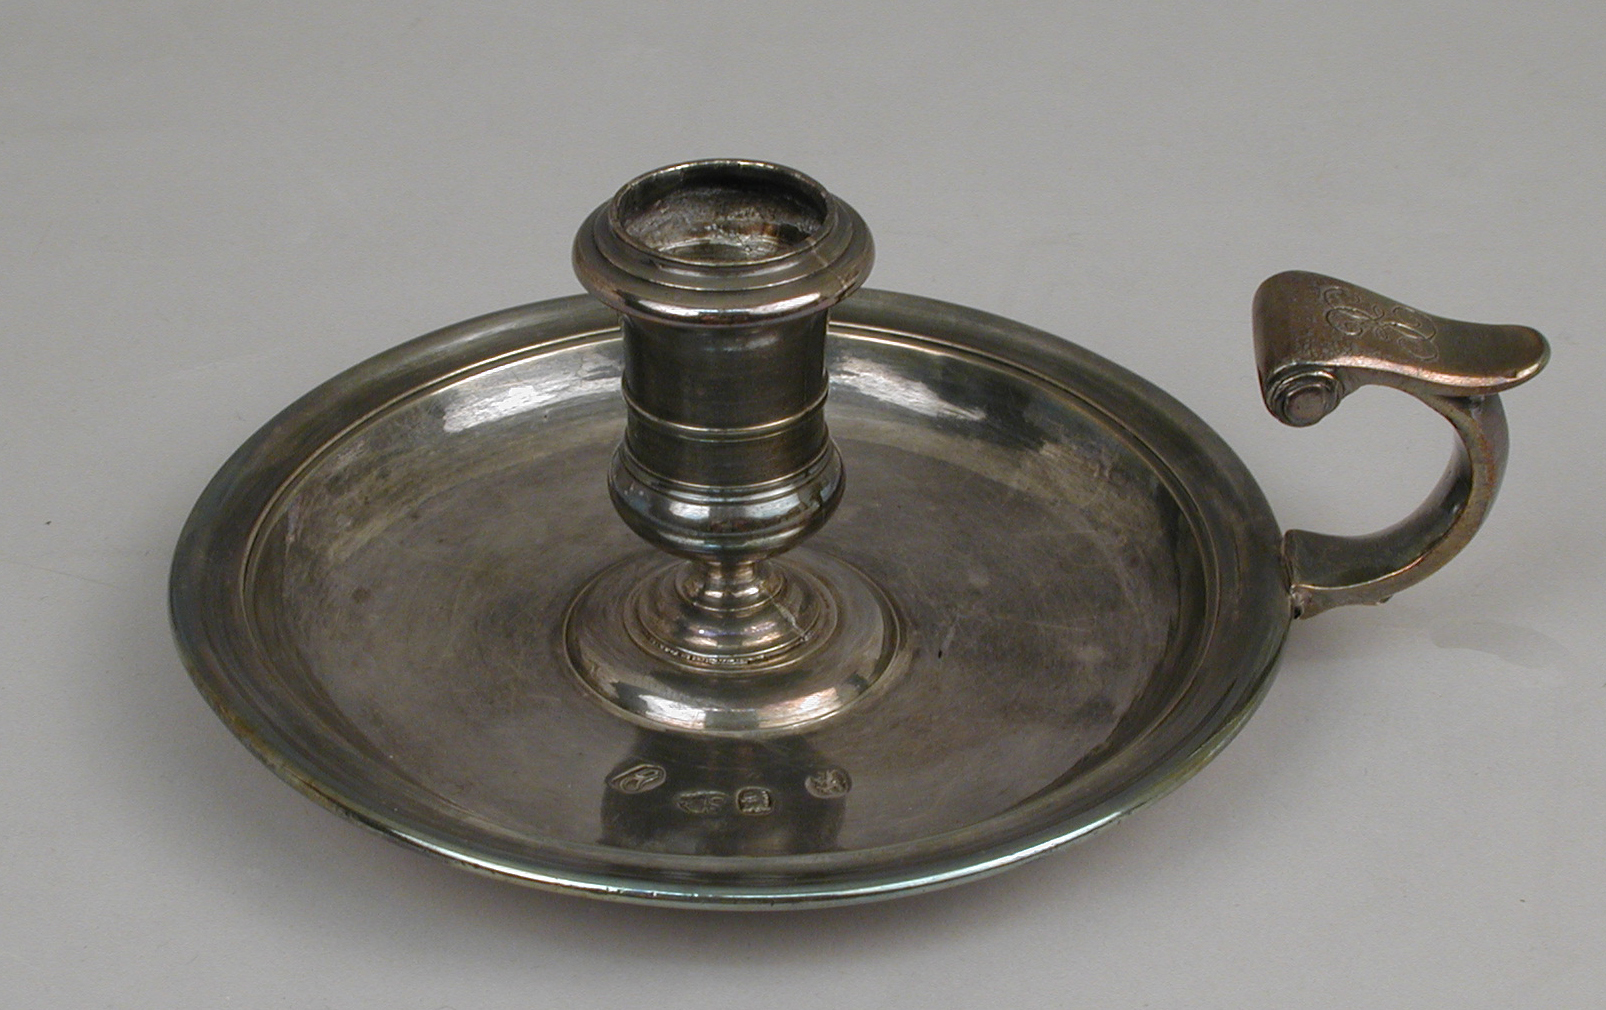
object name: chamber candlestick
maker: thomas folkingham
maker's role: maker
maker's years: 1703-1729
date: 1715-1716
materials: silver